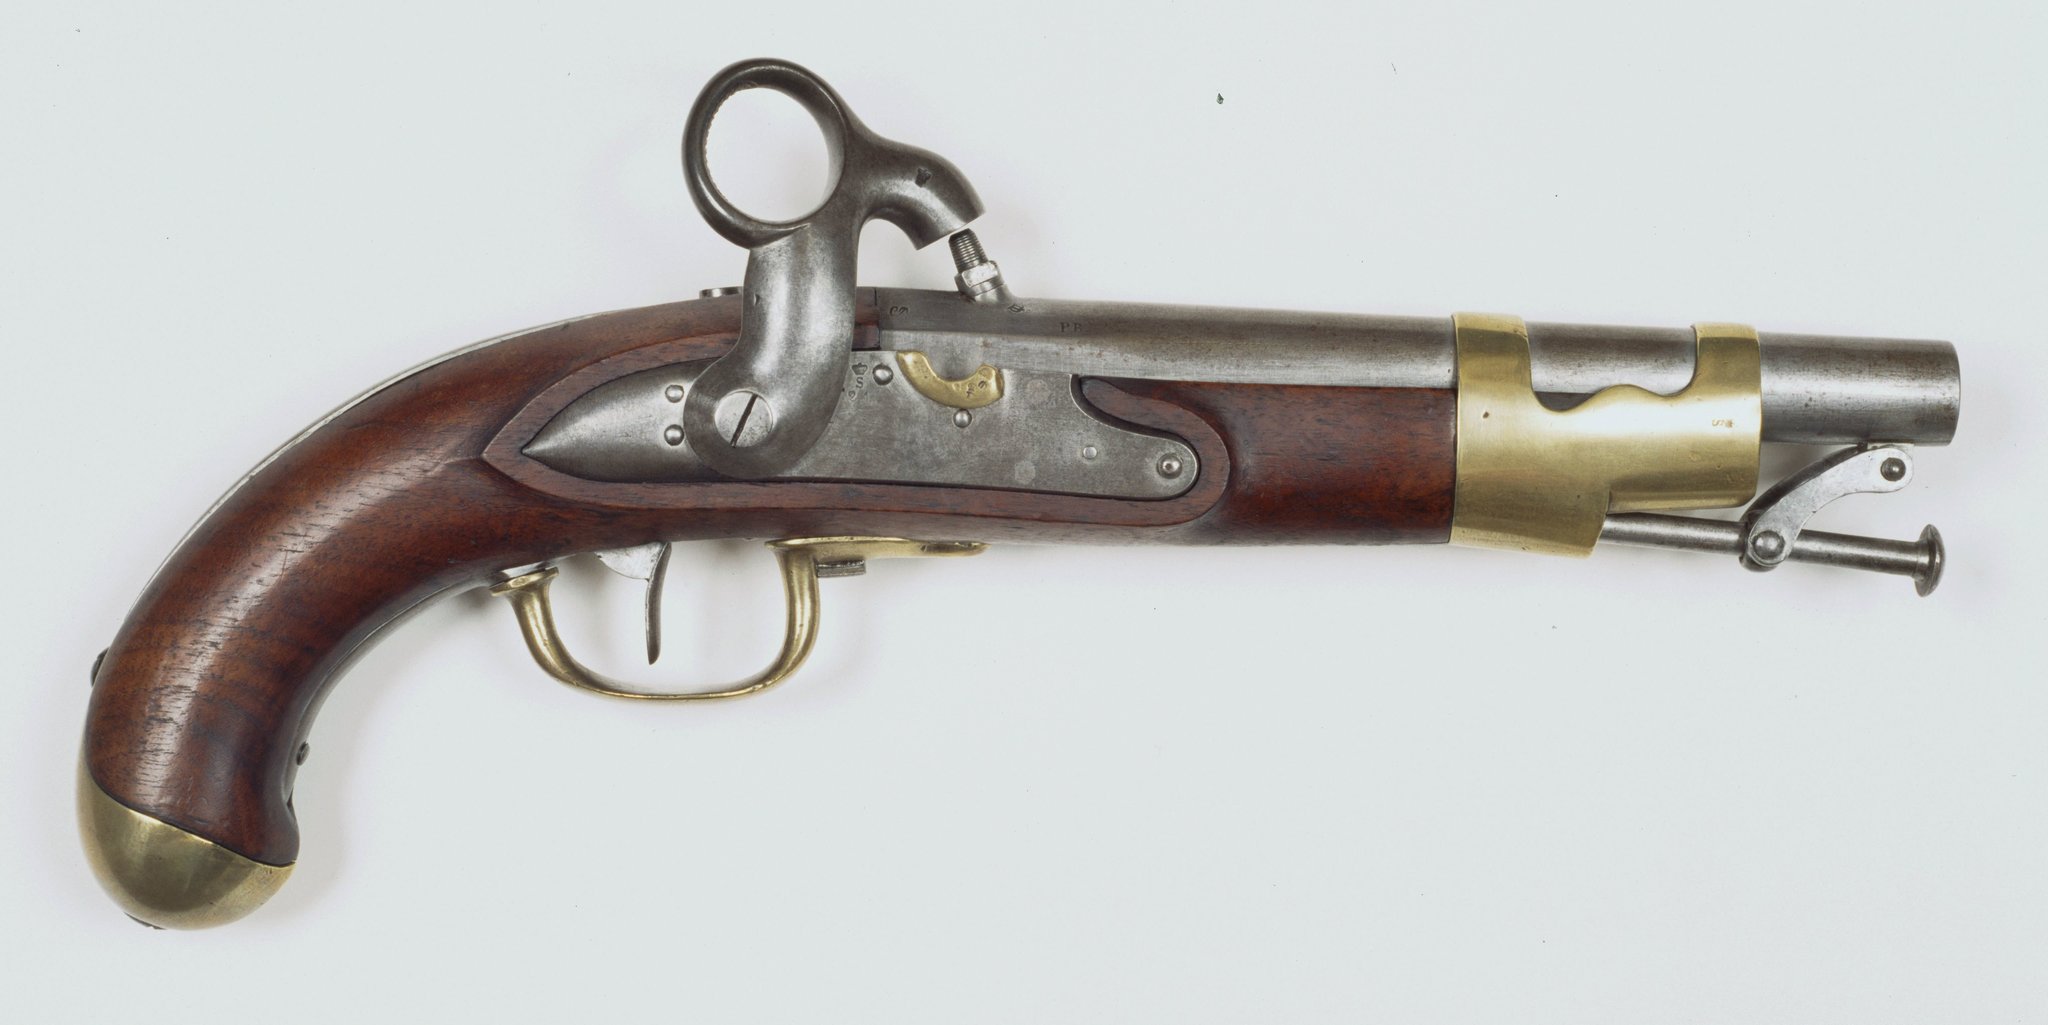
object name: percussion pistol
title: Percussiepistool zware cavalerie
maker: Anonymous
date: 1820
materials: brass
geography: delft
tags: netherlands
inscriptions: : ‘Li no.5 / Re. P. B.’, : ‘1823’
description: Percussiepistool zware cavalerie, model 1820/1841 no. 2 I.I. 1843. Haan met ring, laadstok met beugel. Gladde loop, gemerkt '1823' en 'Li. no. 5' en `Re P. B.'. Messing beslag. Slotplaat met panresten.